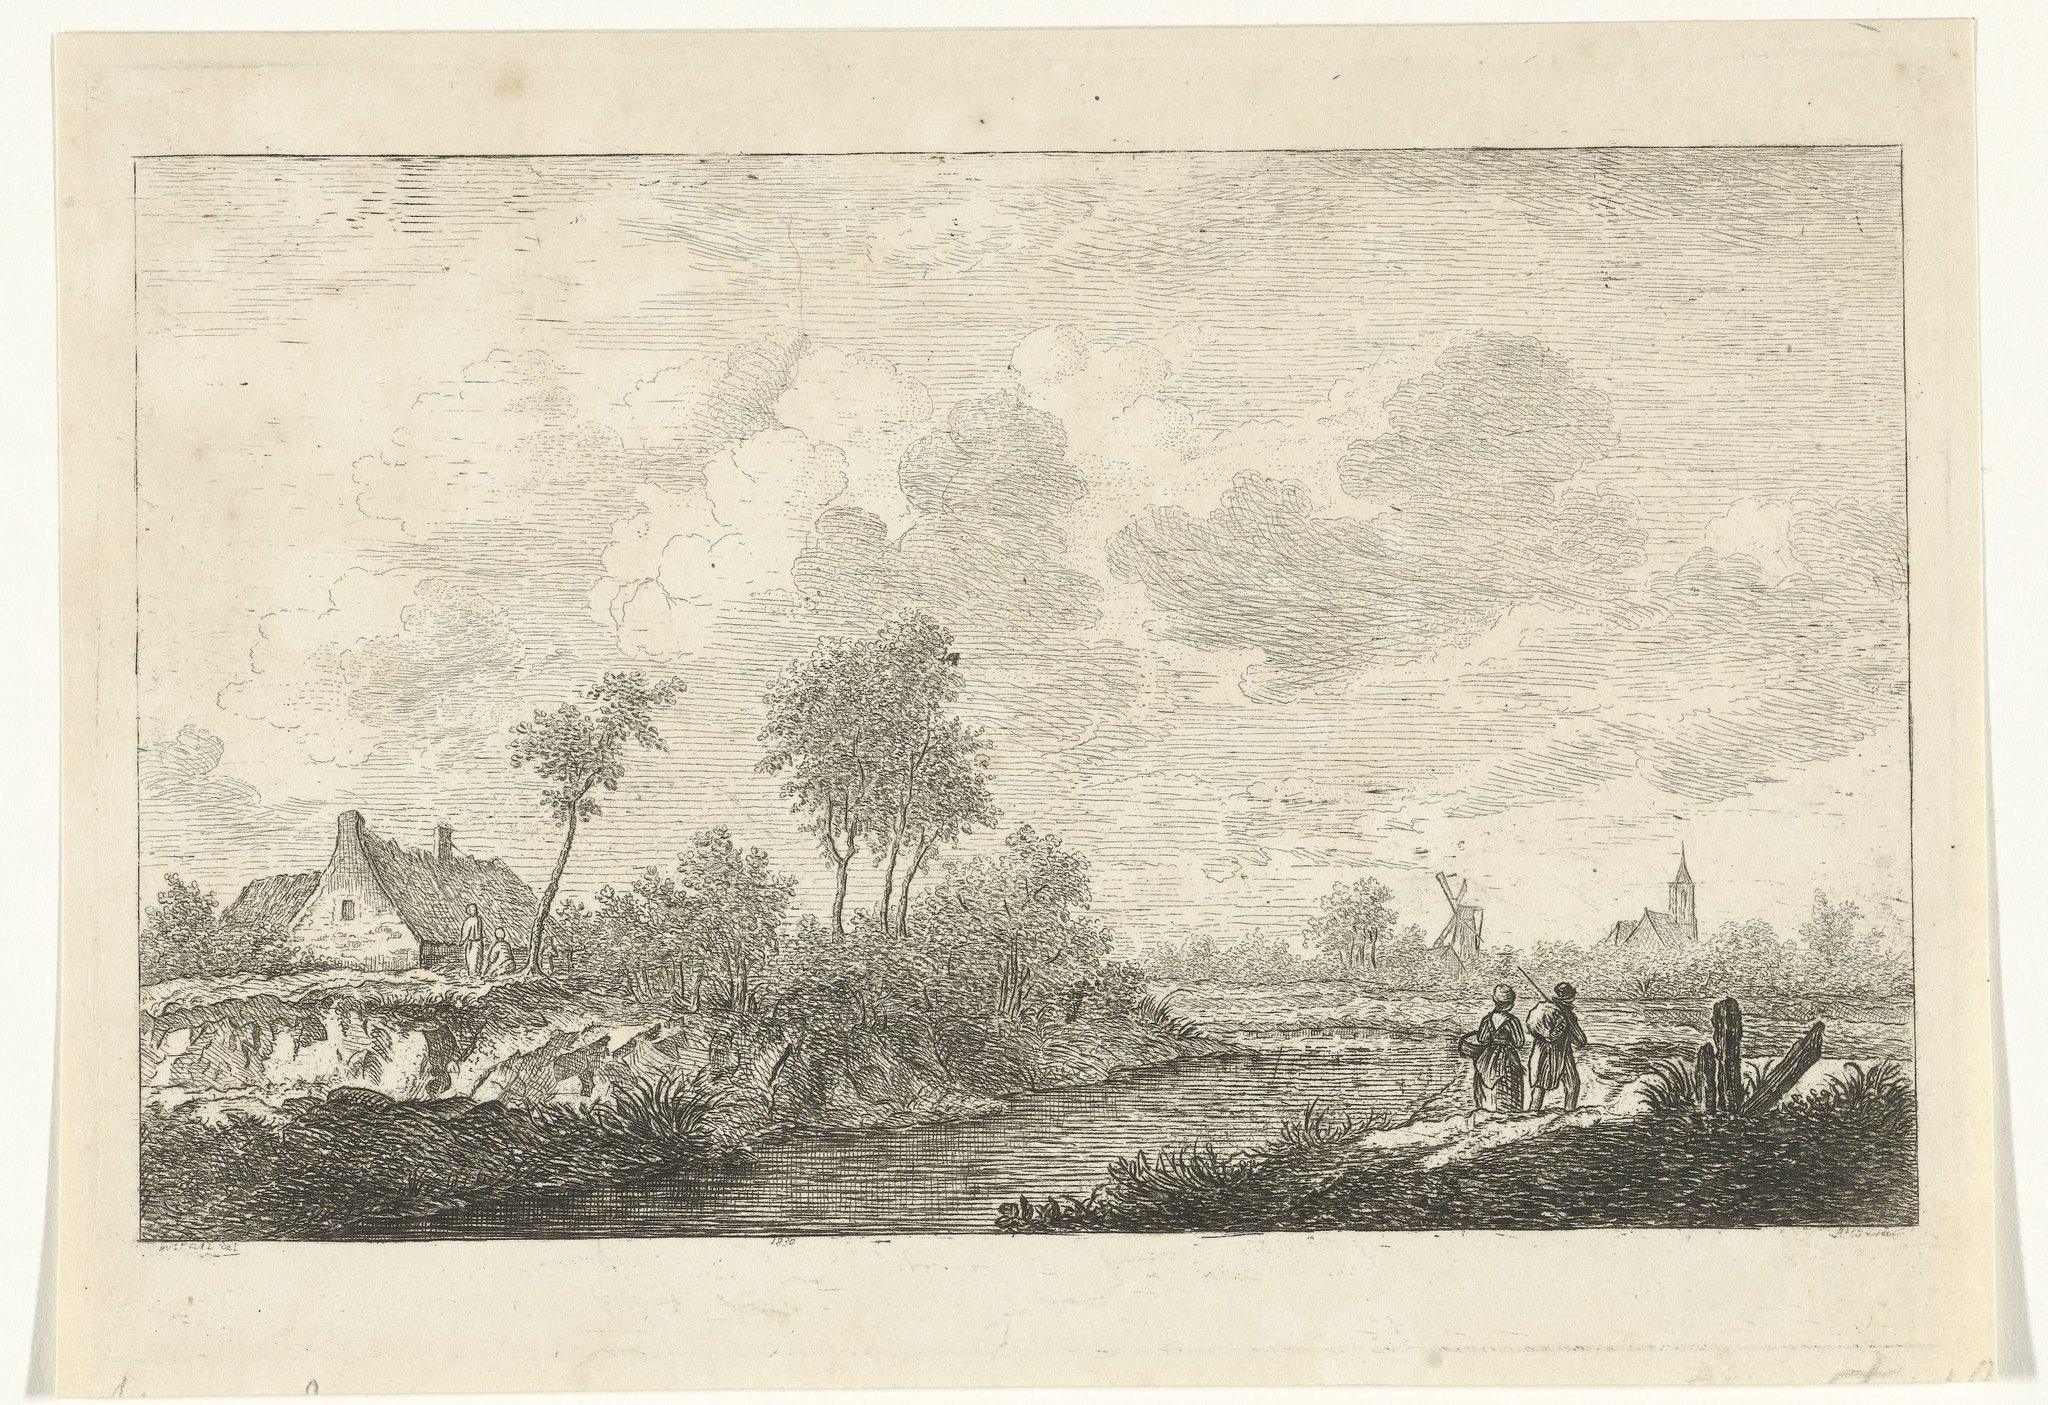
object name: print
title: Rivierlandschap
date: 1796-1856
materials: paper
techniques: etching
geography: vaassen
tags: windmill, river (+ landscape with figures, staffage)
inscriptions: collector's mark: Lugt 2228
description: Een man en een vrouw, op de rug gezien, lopen langs een rivier. Rechts een molen en een kerk aan de horizon. Links aan de overzijde van de rivier een huis en twee figuren.